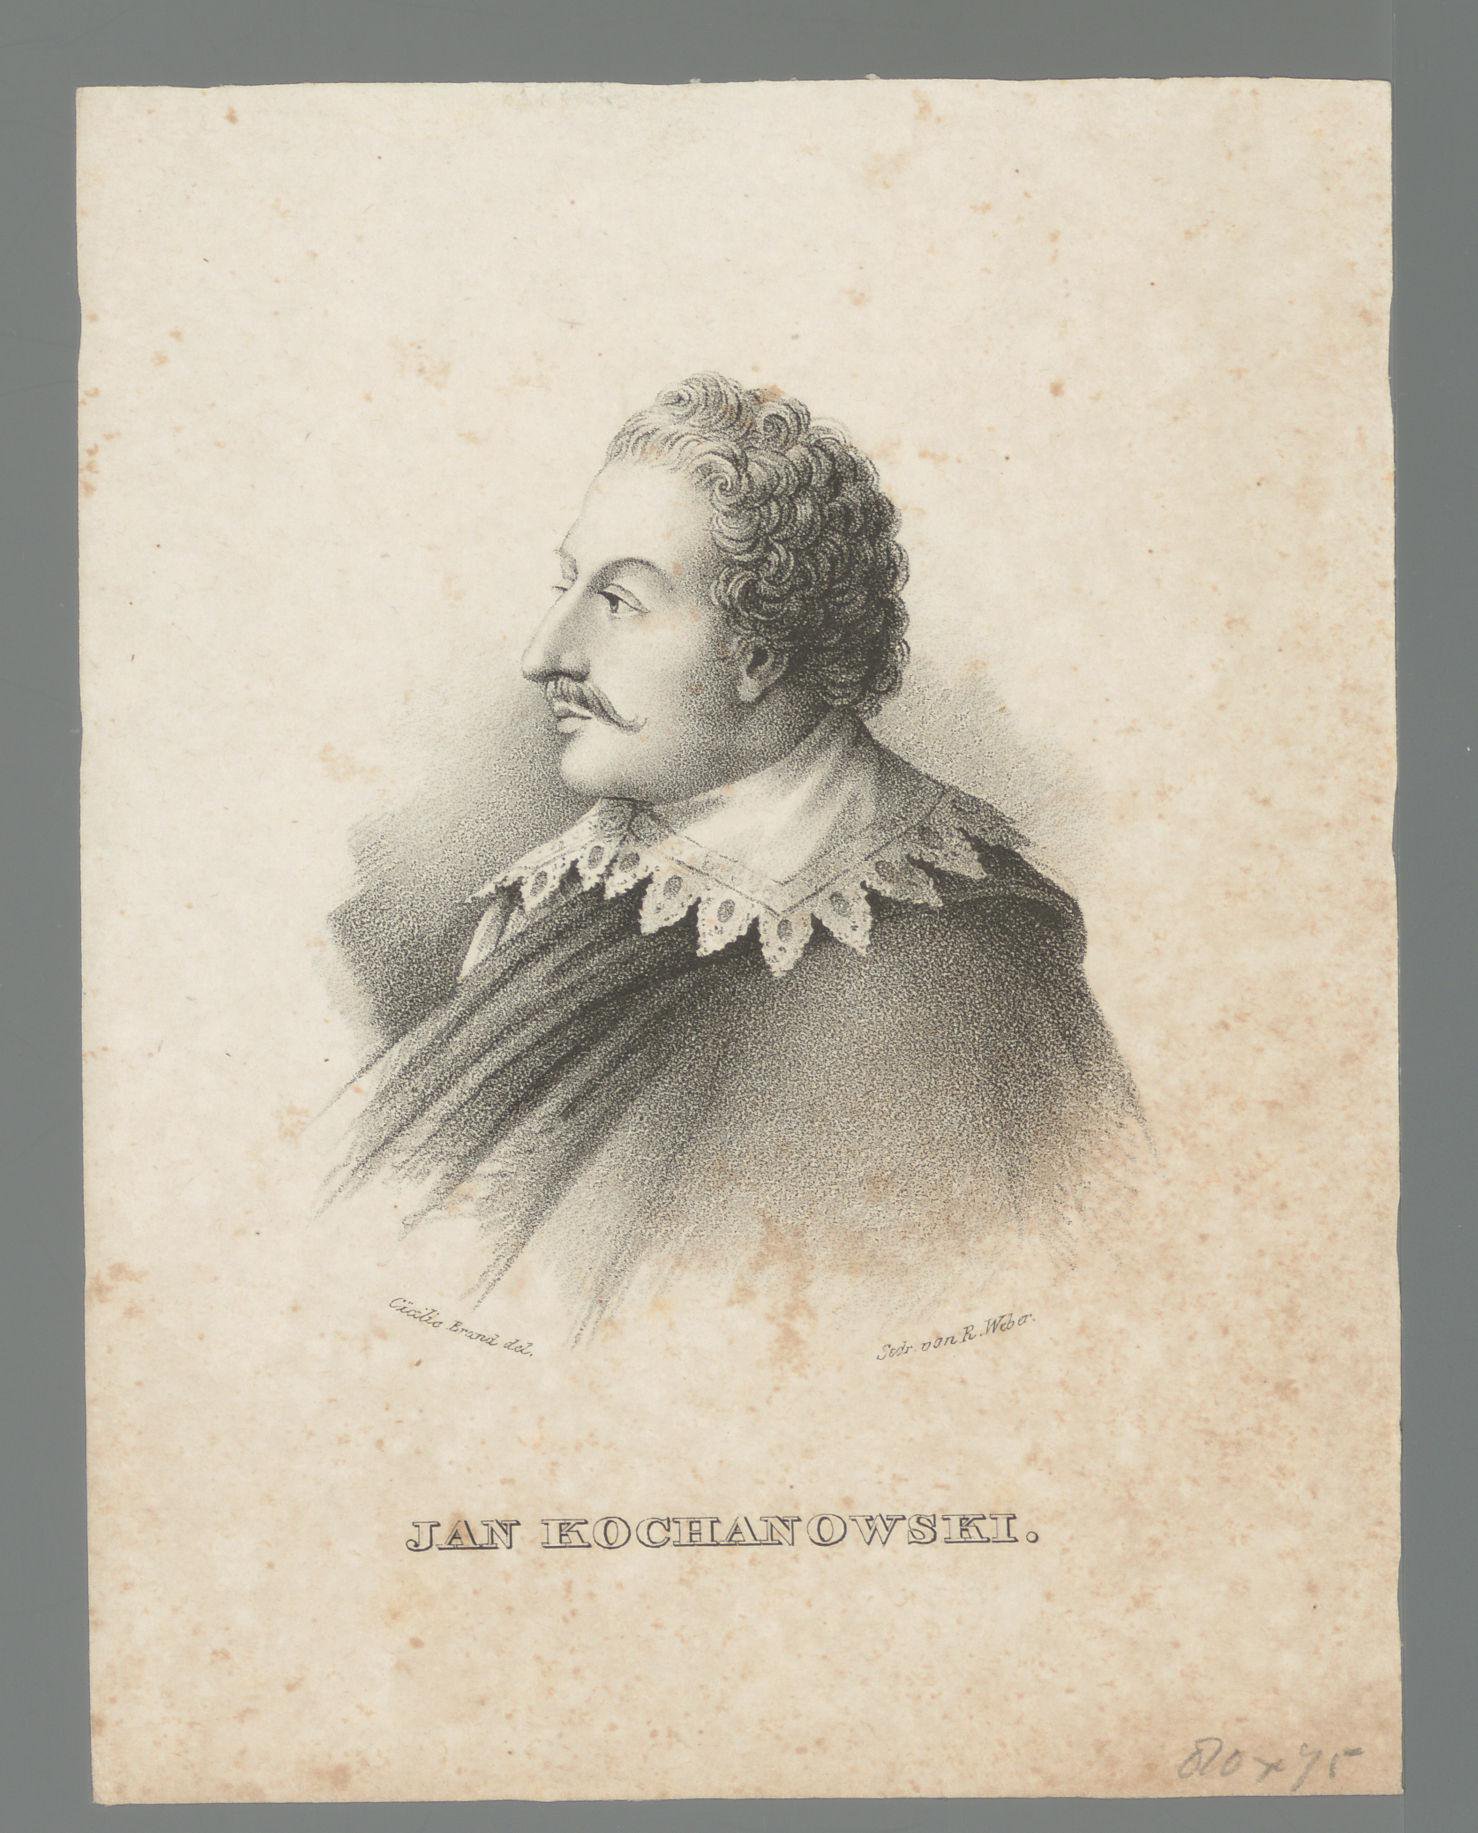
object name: print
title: Portret van Jan Kochanowski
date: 1825-1850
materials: paper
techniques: lithograph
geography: leipzig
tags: moustache, adult man, historical persons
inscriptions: collector's mark: Lugt 2228